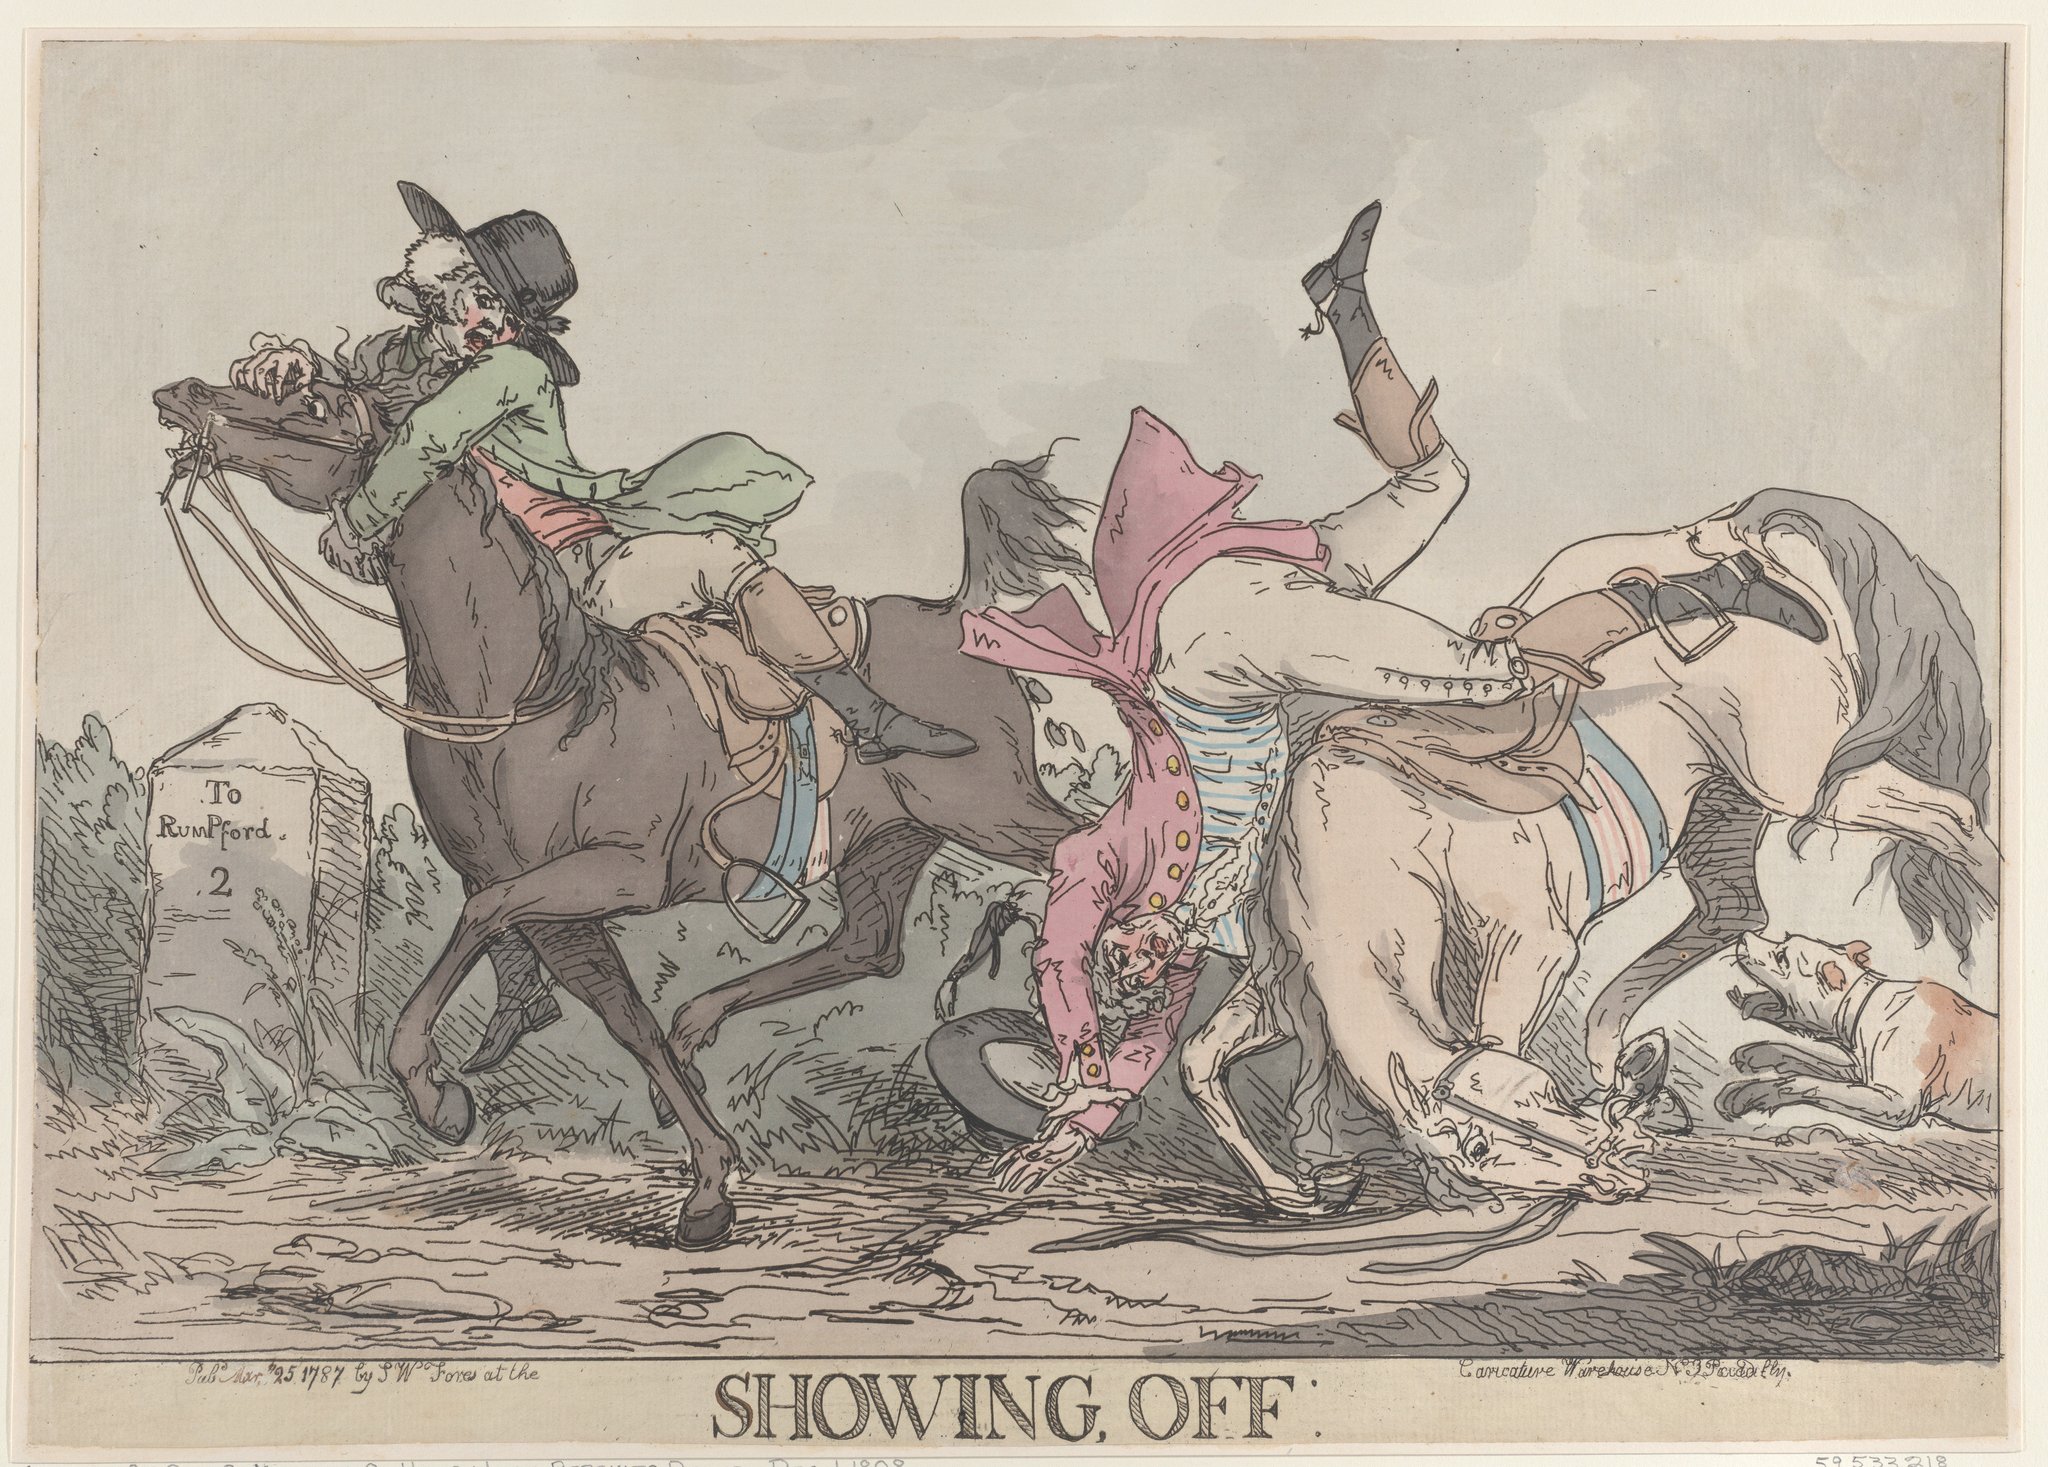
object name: print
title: Showing Off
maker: thomas rowlandson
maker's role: artist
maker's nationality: british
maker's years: 1757-1827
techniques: etching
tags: satire,men,dogs,horses